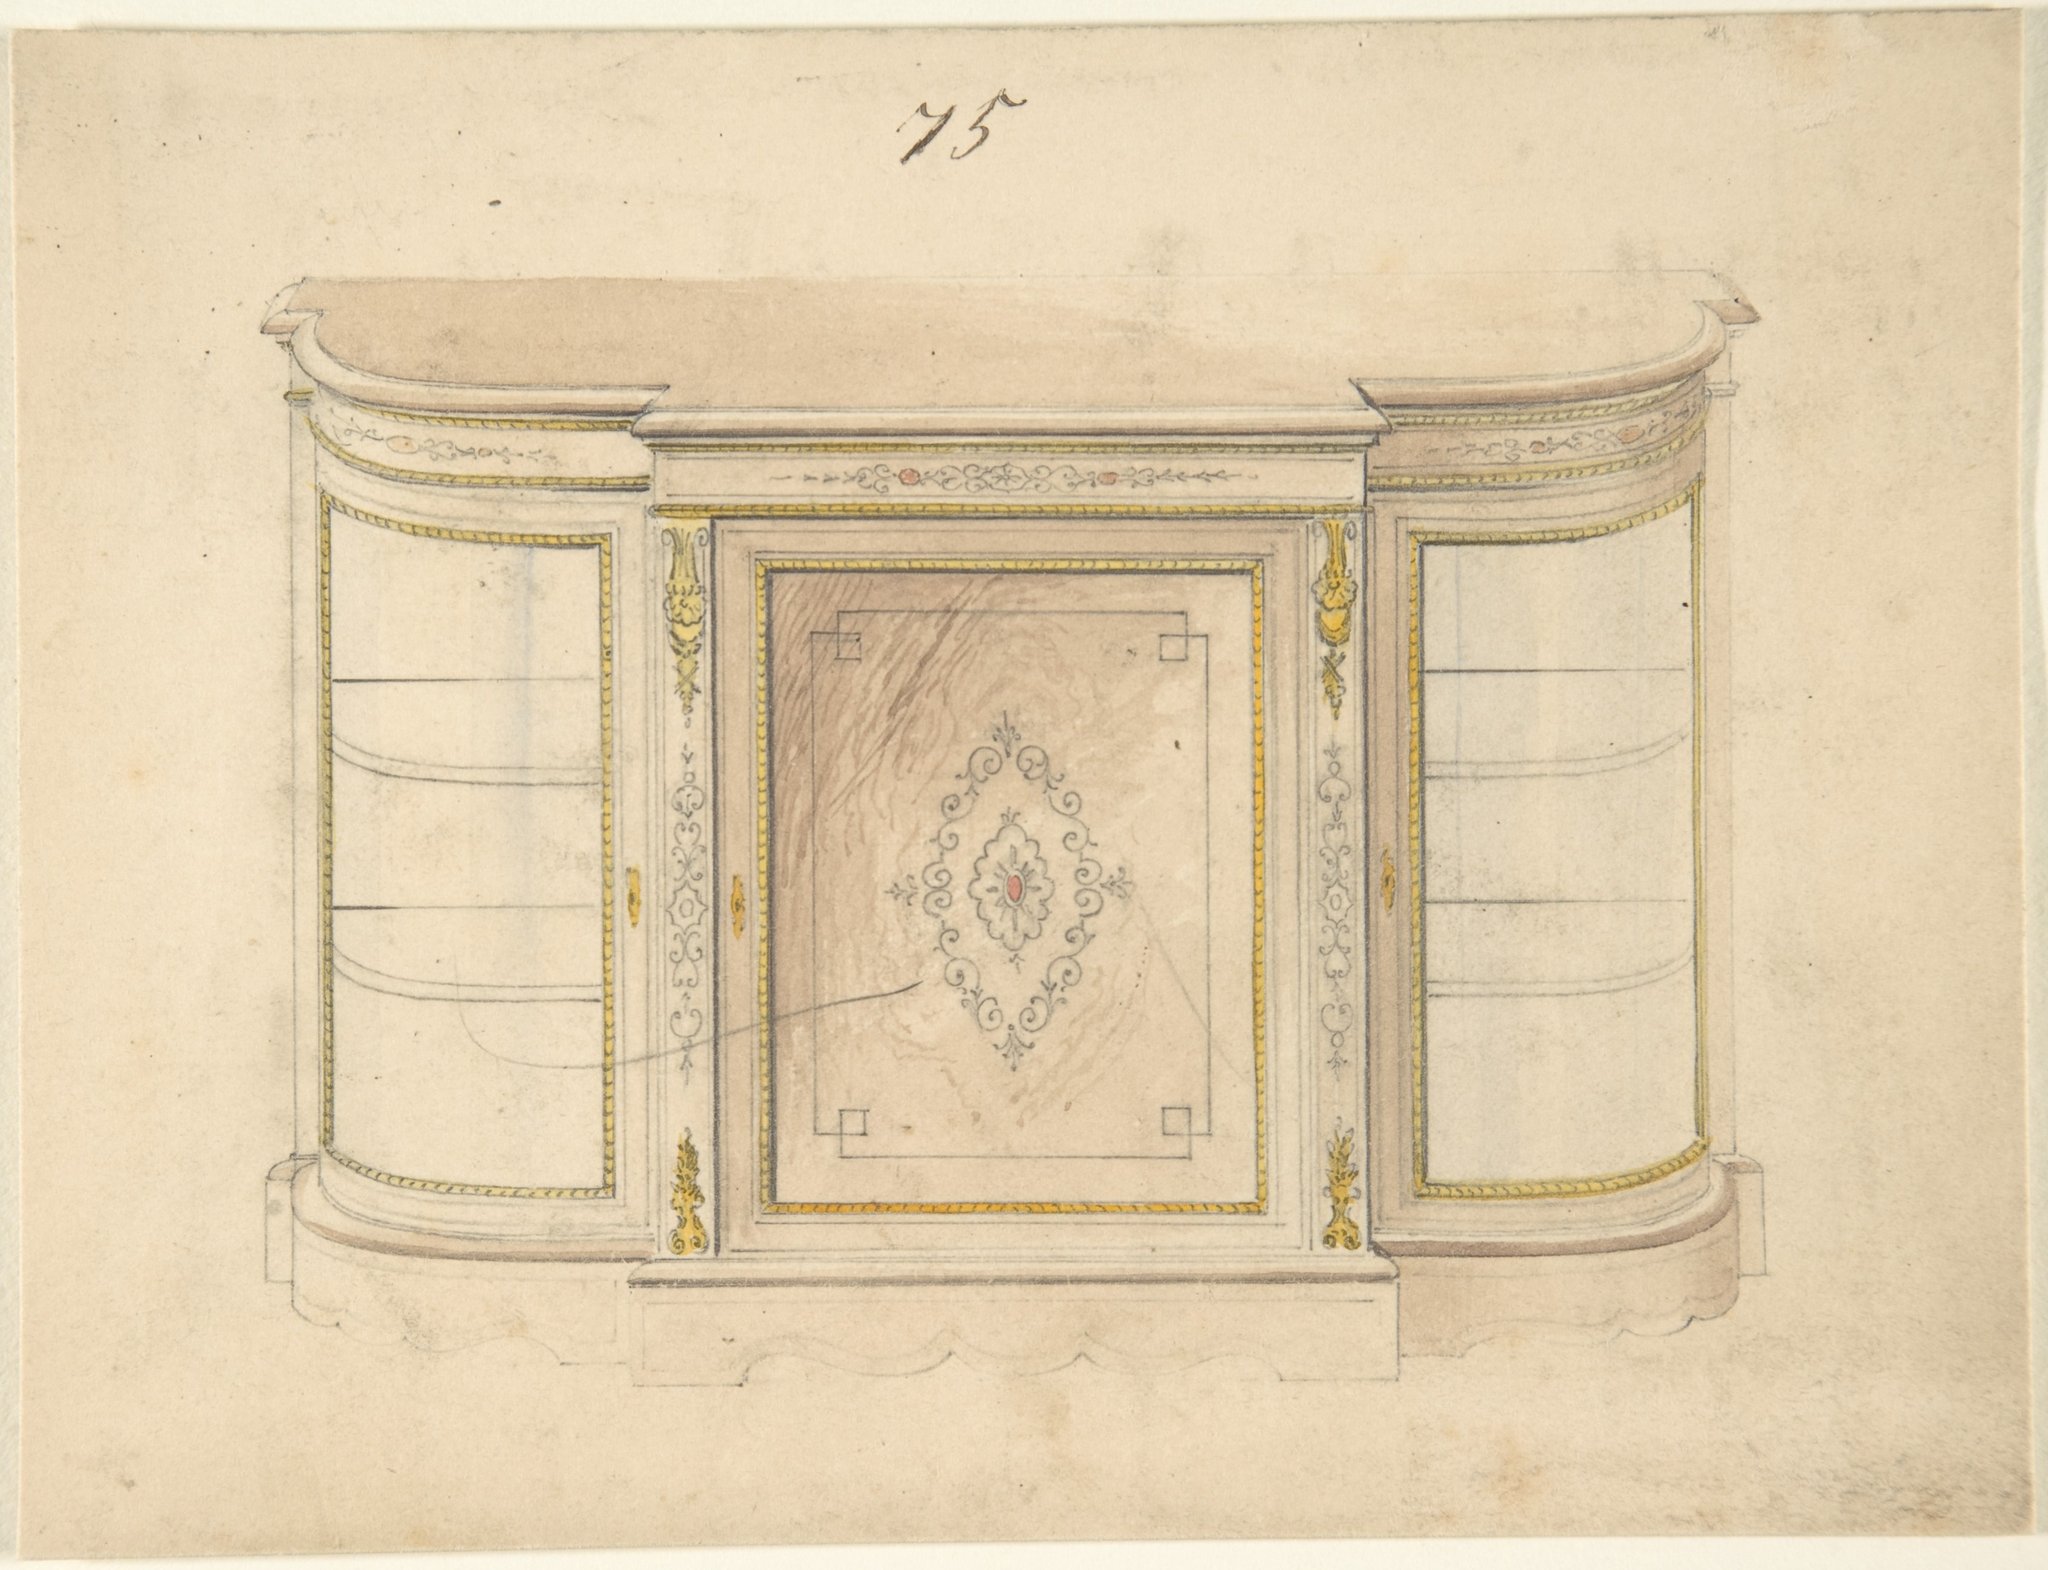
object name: drawing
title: Cabinet Design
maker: anonymous, british, 19th century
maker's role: artist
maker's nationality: british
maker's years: 1800-1900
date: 1801-1900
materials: graphite, ink, watercolor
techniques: pen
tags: cabinets